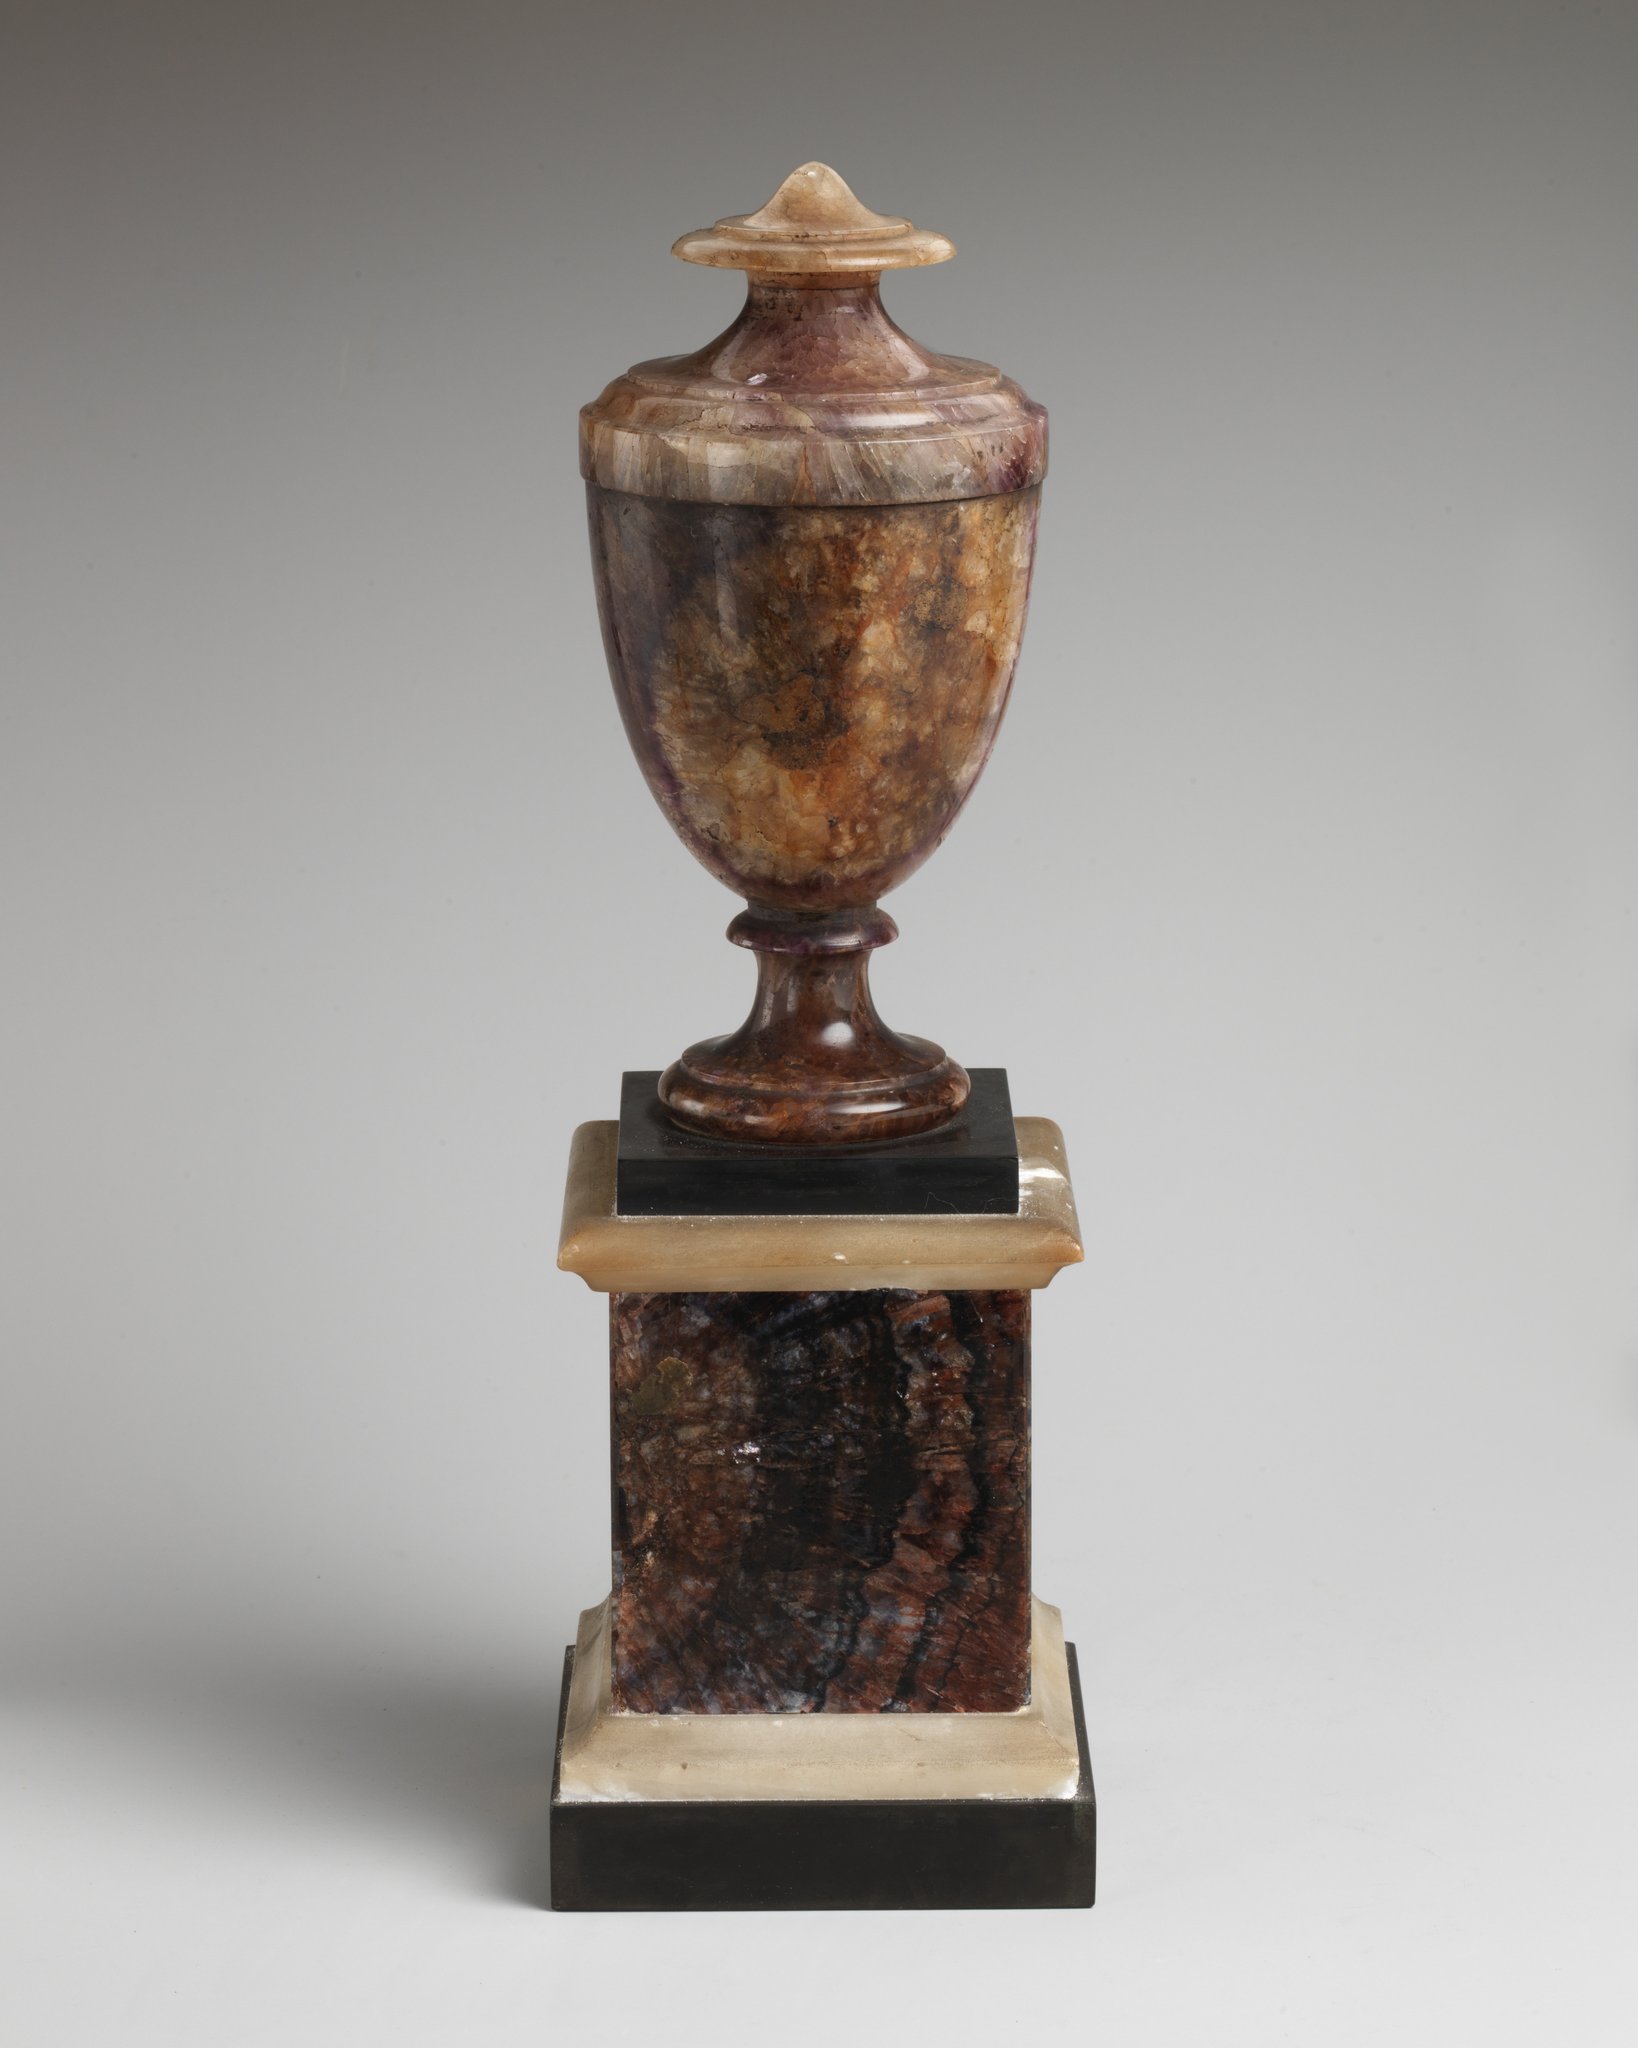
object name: ornament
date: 1770-1780